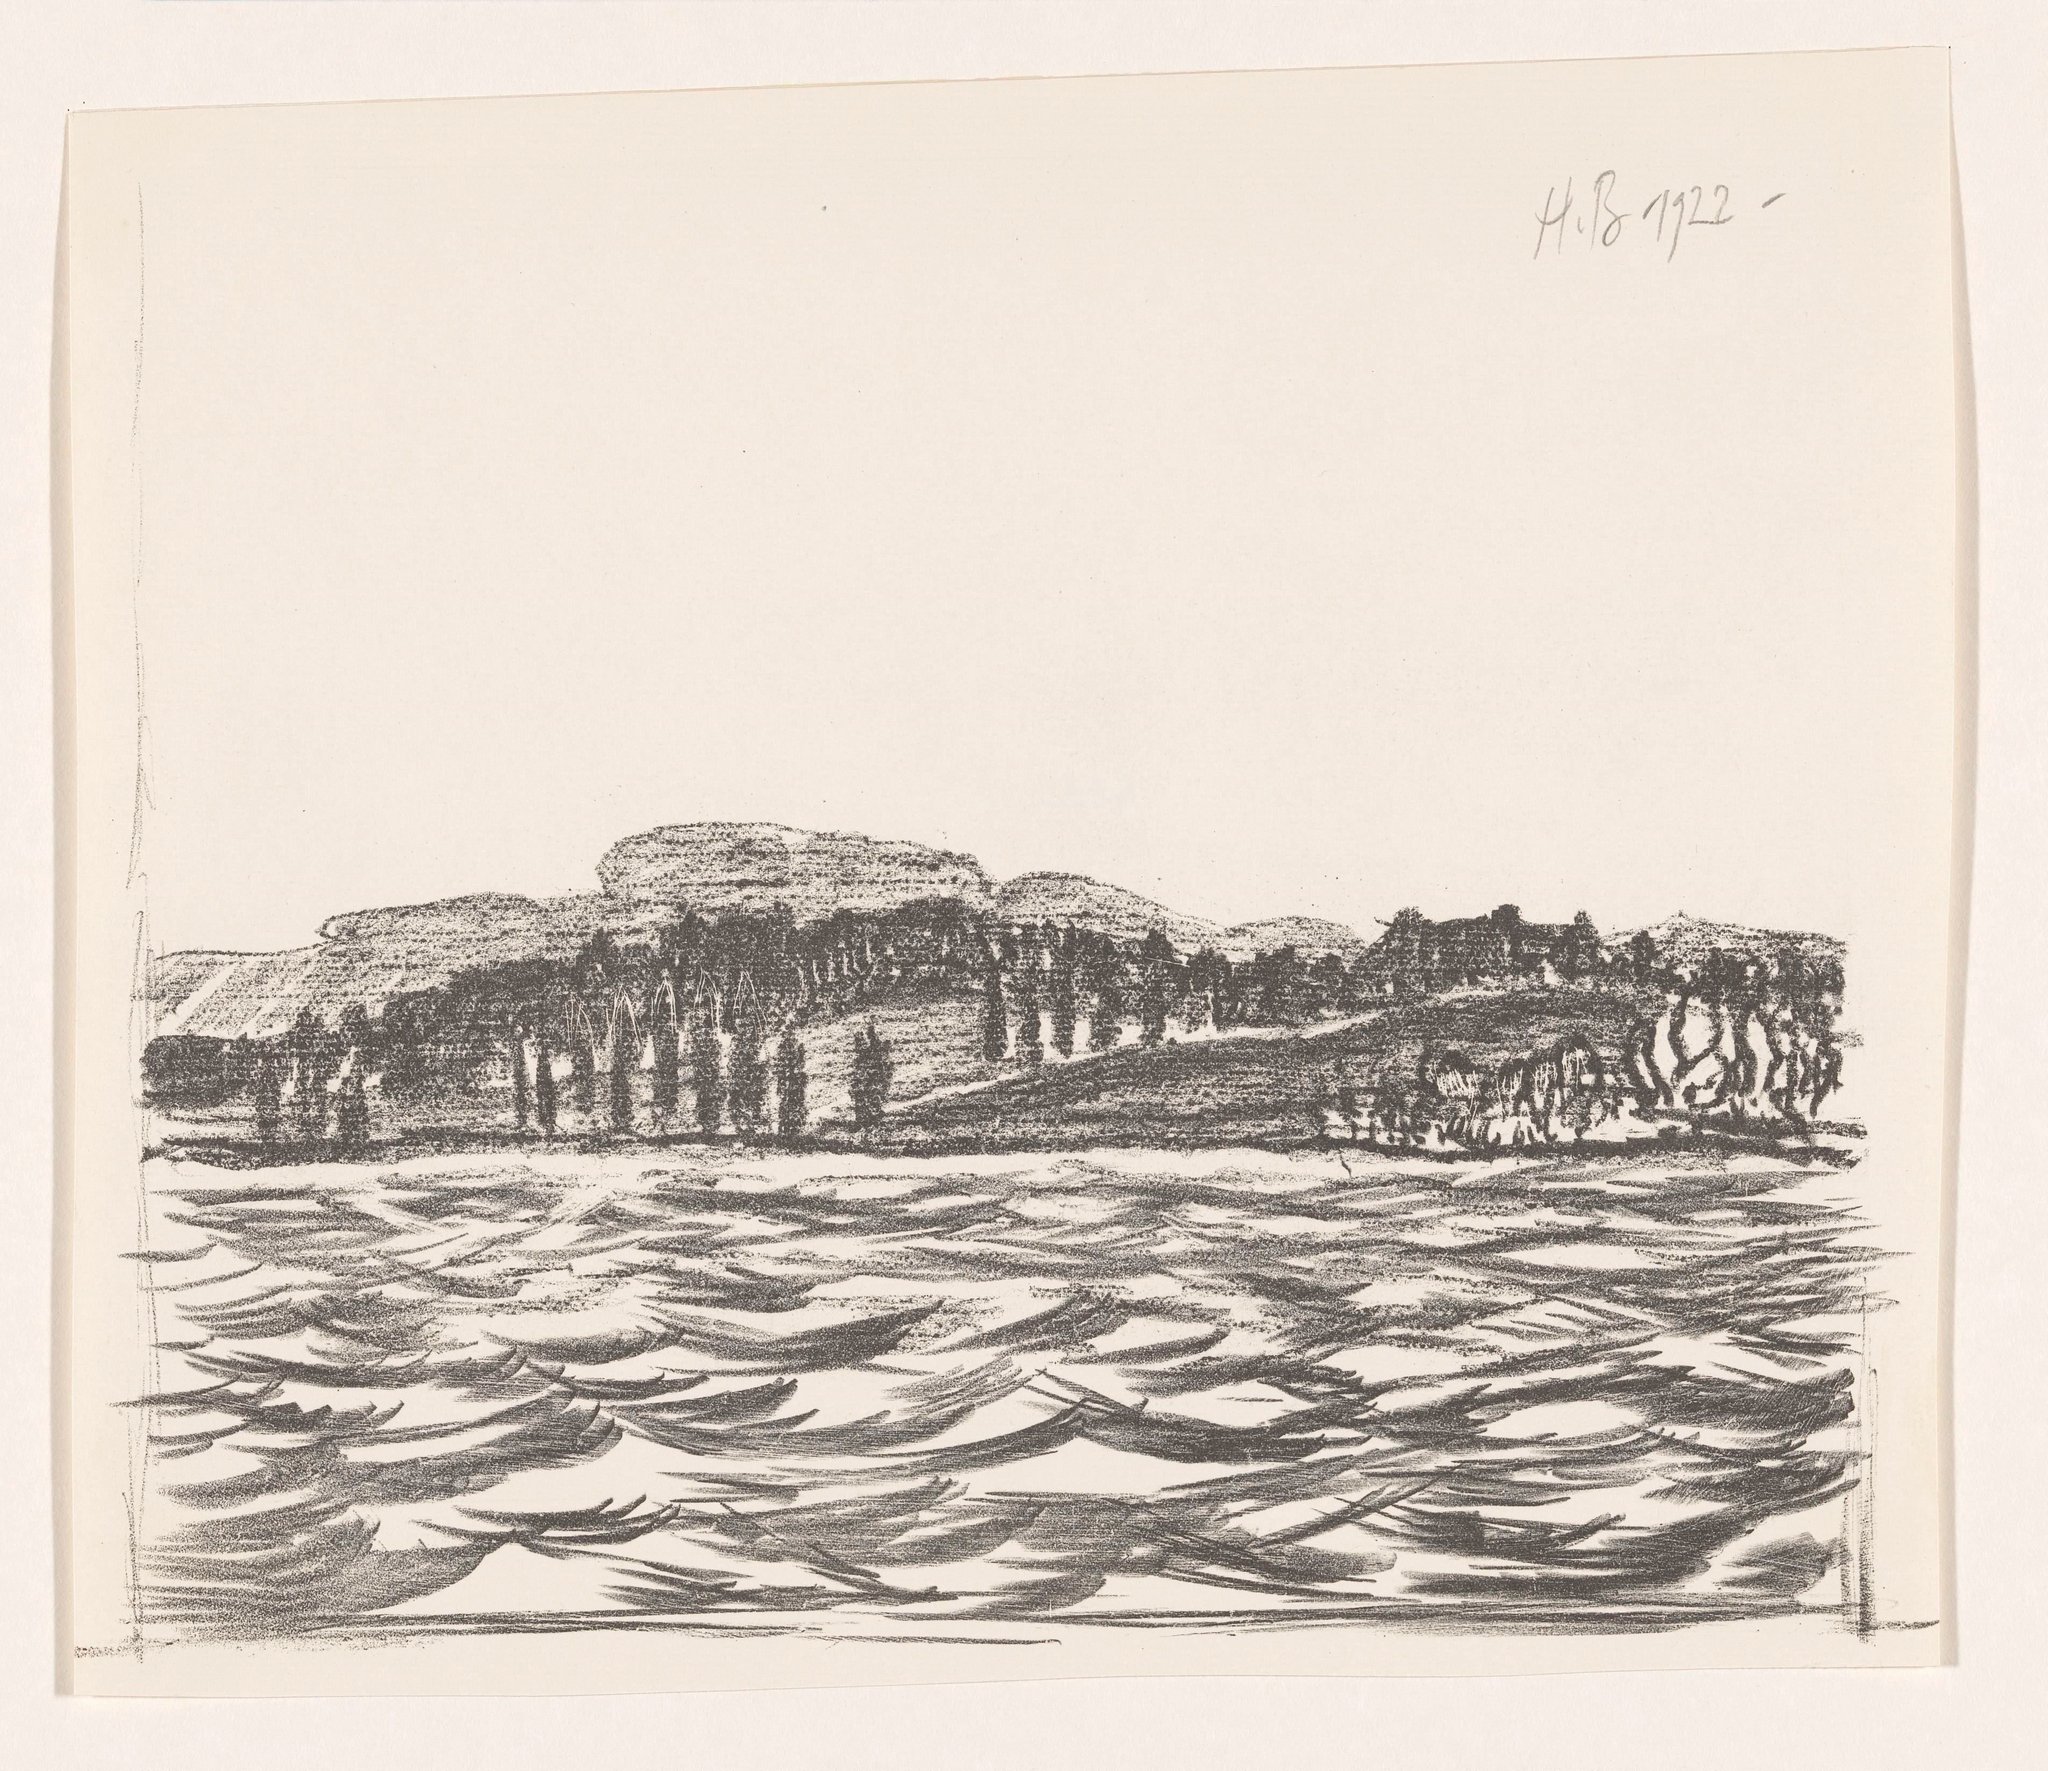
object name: print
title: Starnberger See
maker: henri braakensiek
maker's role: print maker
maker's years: 1891-1941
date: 1922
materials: paper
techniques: lithograph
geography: munich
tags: low hill country - hh - ideal landscapes, lake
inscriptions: collector's mark: Lugt 2228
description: Met bomen begroeide heuvels grenzend aan de Starnberger See in Beieren.